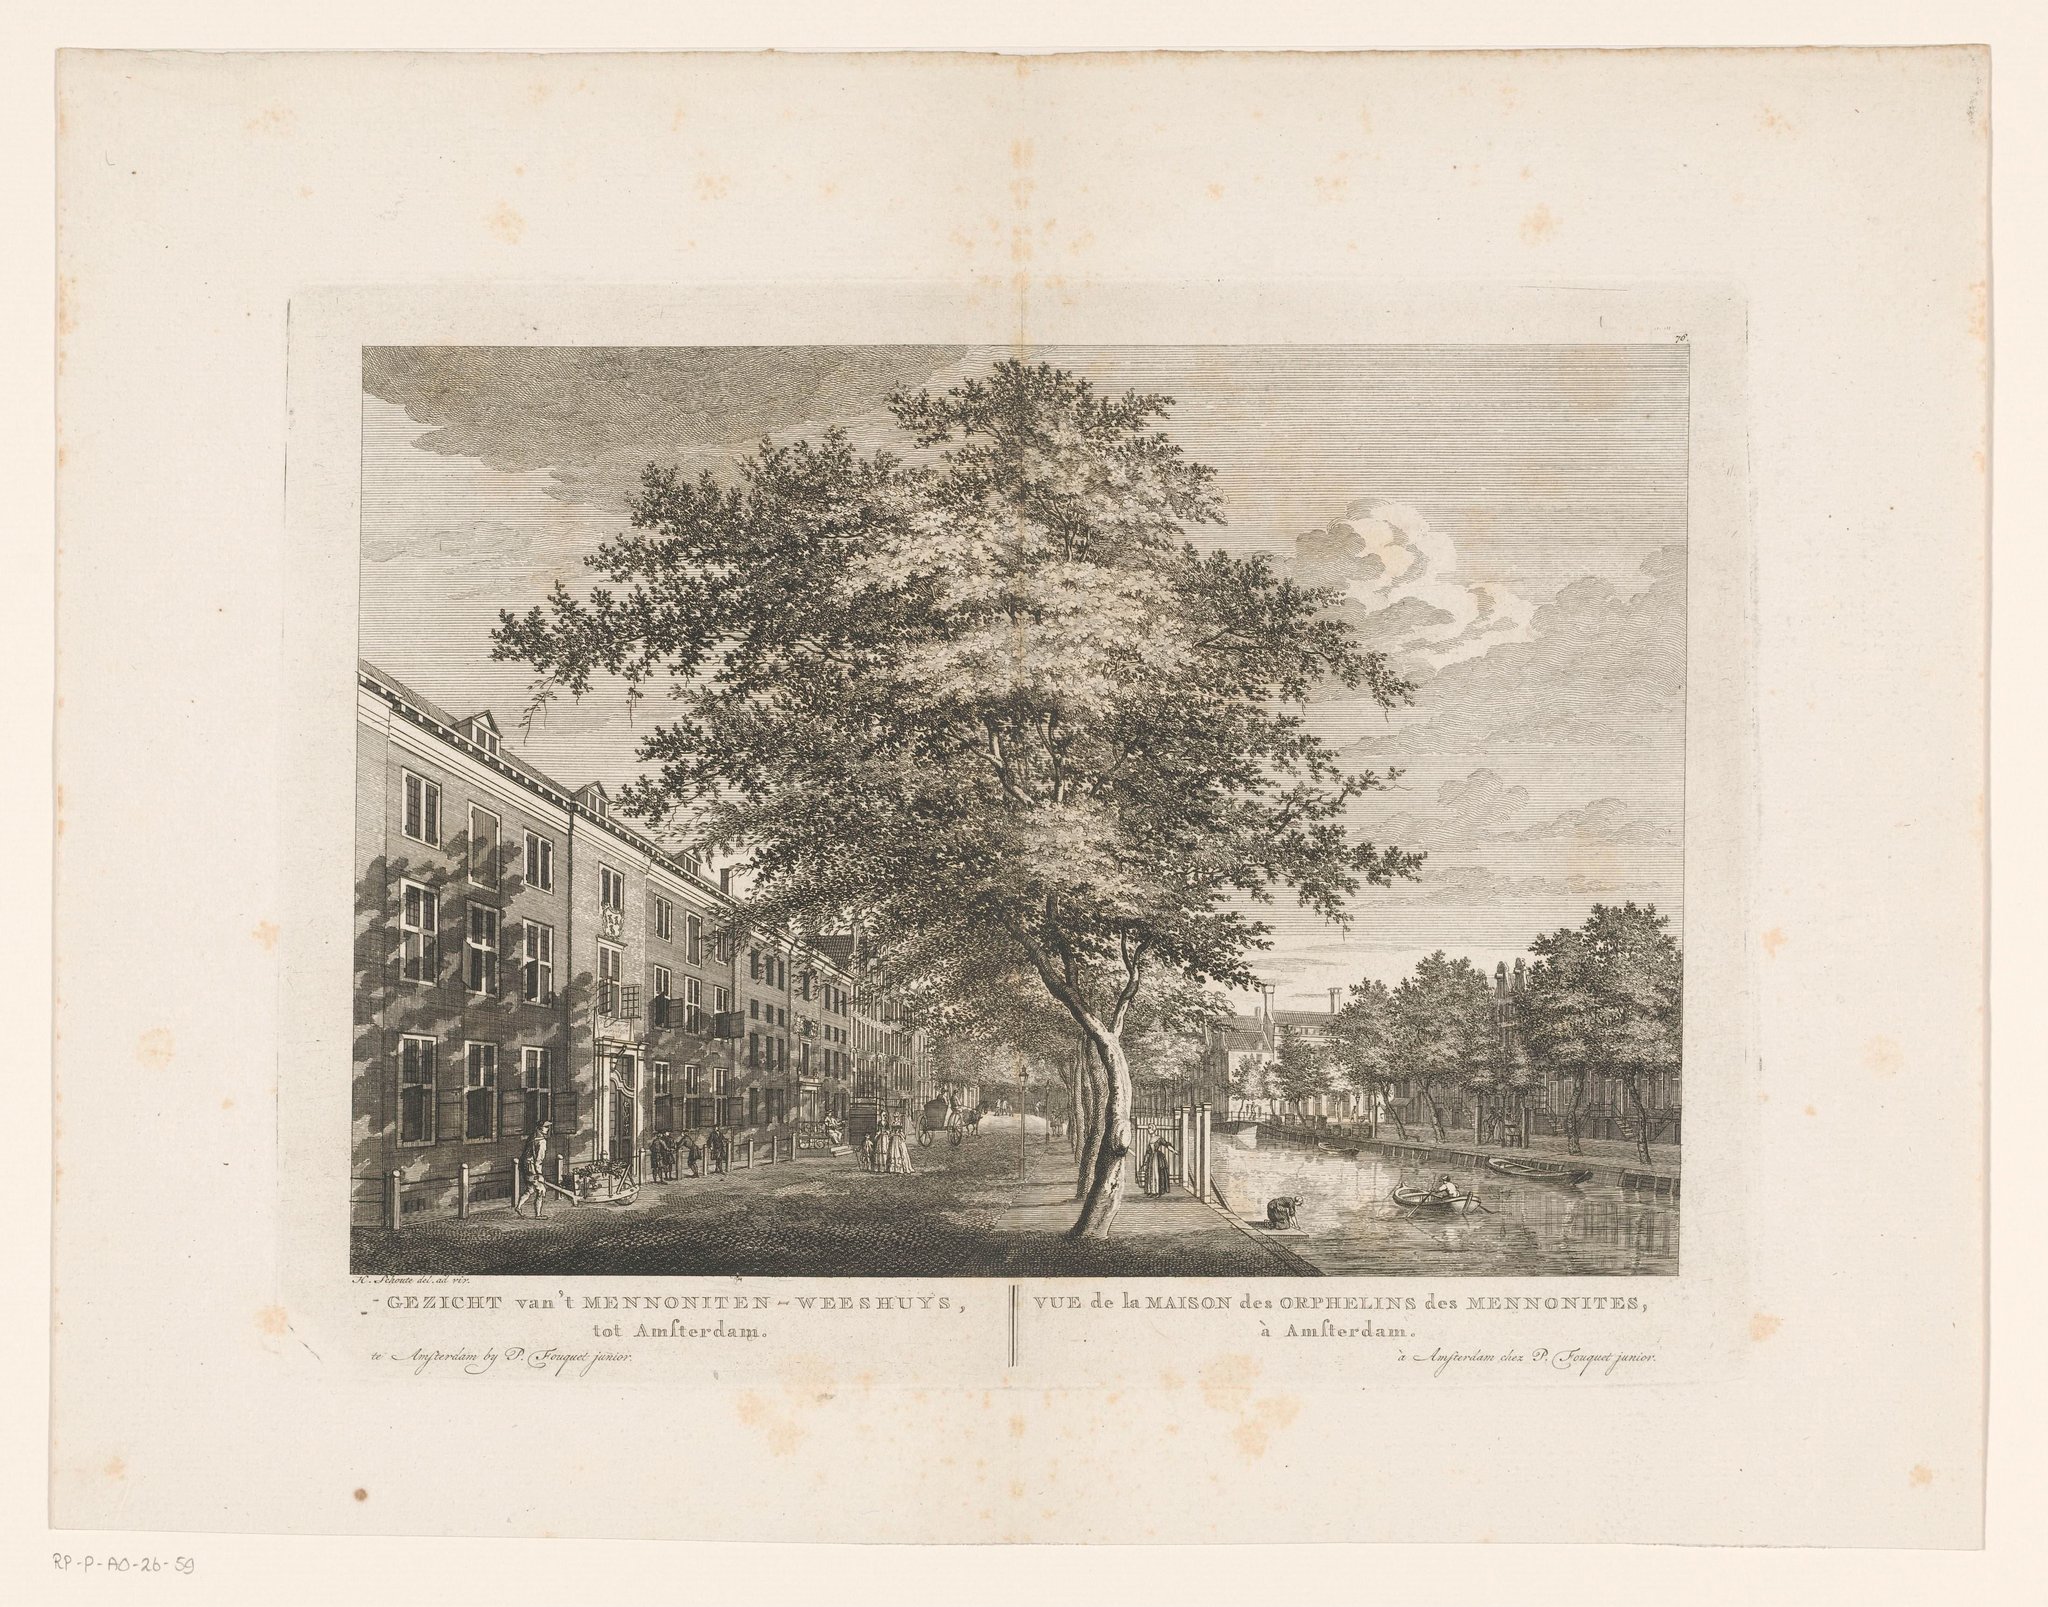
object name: print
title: Gezicht op het Doopsgezinde Weeshuis te Amsterdam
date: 1770-1783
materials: paper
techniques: engraving, etching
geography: amsterdam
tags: orphanage, canals, waters (in city) (+ city(-scape) with figures, staffage), street (+ city(-scape) with figures, staffage)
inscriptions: collector's mark: Lugt 2228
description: Deze prent is ook gebruikt in de zogenaamde Atlas van Fouquet.* Pierre Fouquet gaf vanaf 1760 stadsgezichten van Amsterdam - naar tekeningen van verschillende kunstenaars, gemaakt door verschillende prentmakers - uit. Deze prenten werden aanvankelijk los of in series verkocht. Zoals toen gebruikelijk kon de koper de prenten zelf laten inbinden. Hiertoe gaf Fouquet tussen 1778 en 1783 een titelblad, plattegrond en inhoudsopgave van de tot dusver 100 uitgegeven prenten uit (1). Gezien de inhoud afhankelijk was van wat de koper had verzameld verschilt de inhoud van de verschillende bewaarde Fouquetatlassen onder deze titel sterk. Ook zijn er exemplaren bekend waar tevens andere prenten aan zijn toegevoegd. Omdat er behoefte bleek aan uitleg bij de platen werd in 1783 een nieuwe versie van de atlas uitgegeven, aangevuld met tekst en twee prenten. De aangegeven volgorde veranderde maar de platen van de al eerder uitgegeven prenten bleven ongewijzigd. Deze uitgave werd in opdracht van Fouquet gedrukt bij Daniël Jean Changuion en Petrus den Hengst (2). Een tiental platen werd bijgewerkt en verscheen, met nieuw impressum, in het vervolg van Wagenaars geschiedenis van Amsterdam, uitgeven door Petrus Conradi en Folkert van der Plaats (3). Een aantal jaar na het overlijden van Fouquet kwam Evert Maaskamp met een nieuwe uitgave van de atlas, met verbeterde tekst en toevoeging van twee prenten. Op alle platen verwijderde hij het oude en liet hij zijn eigen impressum zetten (4). De huidige staat van de prent komt voor in exemplaren van de onder (1) en (2) genoemde werken. * Onder de Atlas van Fouquet of Fouquetatlas verstaan we de hieronder vermelde publicaties (1), (2) en (4). (1). Afbeeldingen van de wyd-vermaarde koopstad Amsterdam benevens des zelvs voornaamste gebouwen en gezigten alle naar het leeven getekend / Receuil des edifices les plus considerables et des plus belles vues, de la fameuse ville d'Amsterdam, dessinées d'après nature. Amsterdam: Pierre Fouquet, 1778-1783. (2). Nieuwe atlas, van de voornaamste gebouwen en gezigten der stad Amsterdam, met derzelver beknopte beschryvingen. 2 delen. Amsterdam: Daniël Jean Changuion en Petrus den Hengst [in opdracht van Pierre Fouquet], 1783. (3). Stijl, Simon. Amsterdam, in zyne geschiedenissen, voorregten, koophandel, gebouwen, kerkenstaat, schoolen, schutterye, gilden en regeeringe, beschreeven. Om te dienen ten vervolge op het werk van Jan Wagenaar (…). 10 delen. Amsterdam en Harlingen: Petrus Conradi en Folkert van der Plaats, 1788-1801. (4). Nieuwe atlas, van de voornaamste gebouwen en gezigten der stad Amsterdam. Met derzelver beknopte beschryvingen. Amsterdam: Evert Maaskamp, 1805. * Het aantal vermelde staten is gebaseerd op het aantal gevonden staten. Mogelijk zijn er meer staten van deze prent. Zie RP-P-1998-767 voor derde bekende staat.